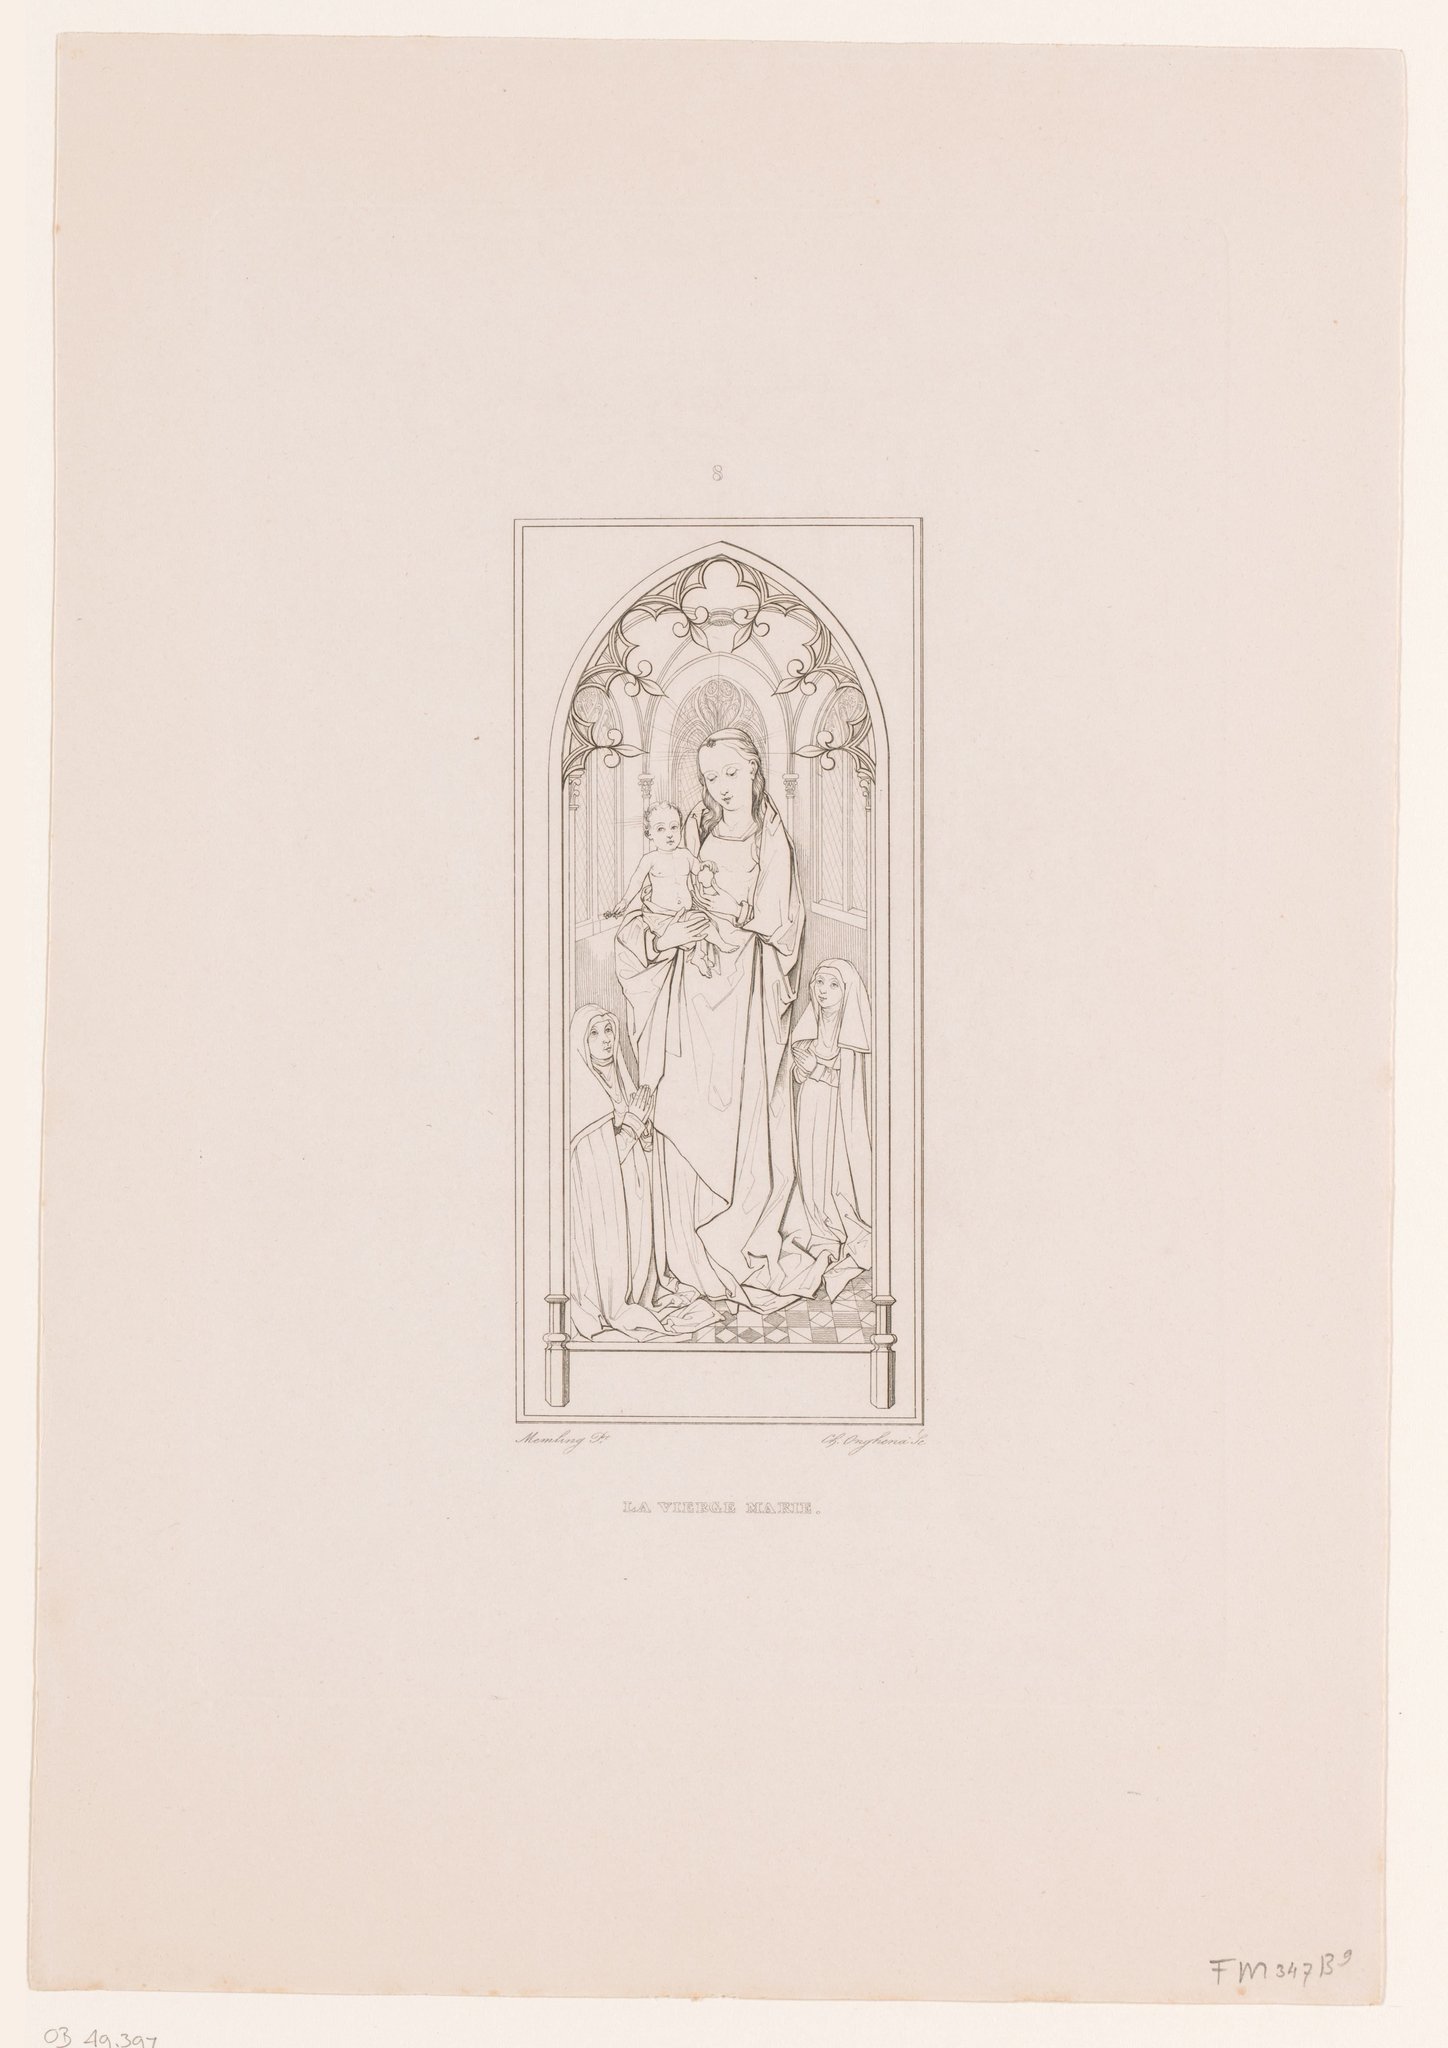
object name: book illustration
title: Maria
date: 1841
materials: paper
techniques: etching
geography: brussels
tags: the virgin martyr ursula of cologne; possible attributes: arrow, banner with red cross, cloak of ermine, crown, ship, relics (and reliquaries)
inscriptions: collector's mark: Lugt 2228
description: Prent uit: Delepierre, Octave en Auguste Voisin. La Châsse de St. Ursule. Brussel: Société des Beaux-Arts, [1841].